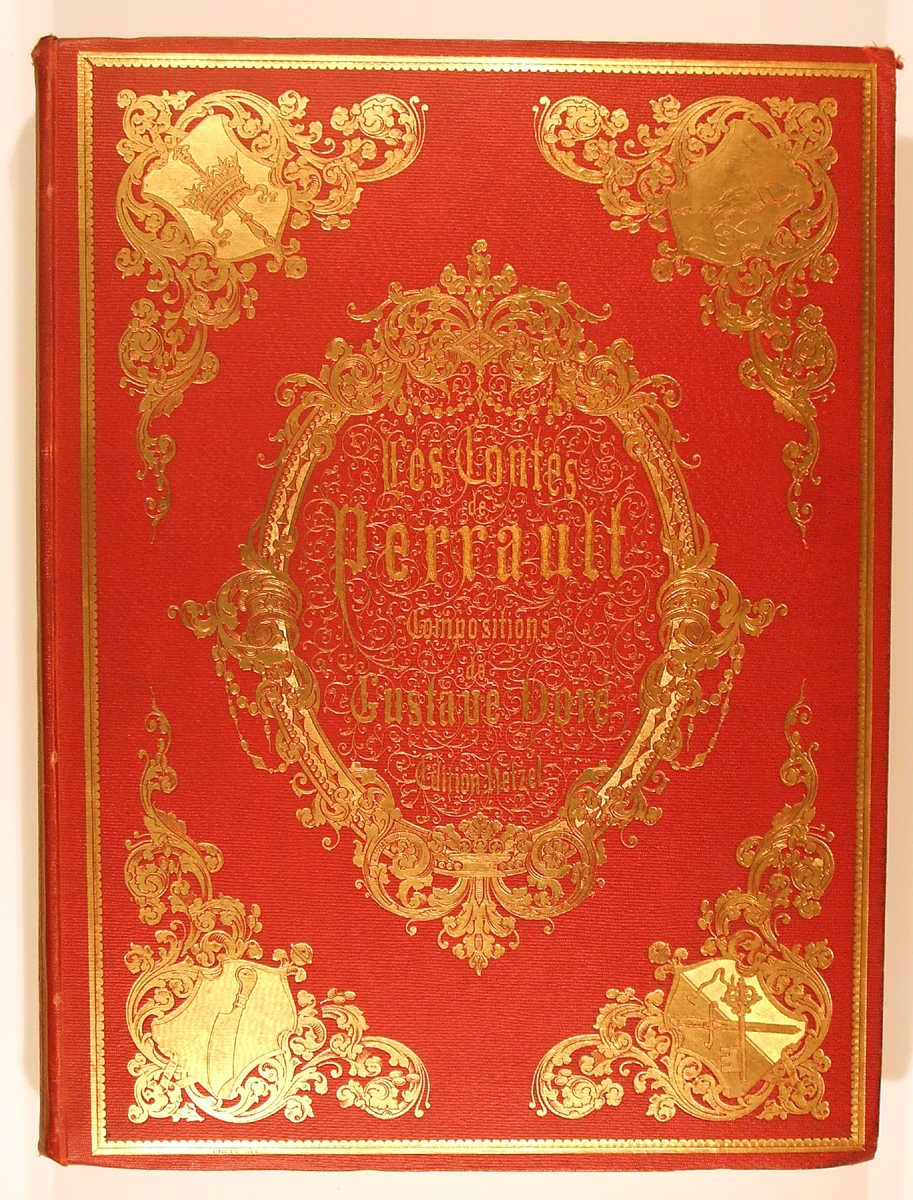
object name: book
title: Les Contes de Perrault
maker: charles perrault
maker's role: author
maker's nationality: french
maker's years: 1628-1703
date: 1864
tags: coat of arms